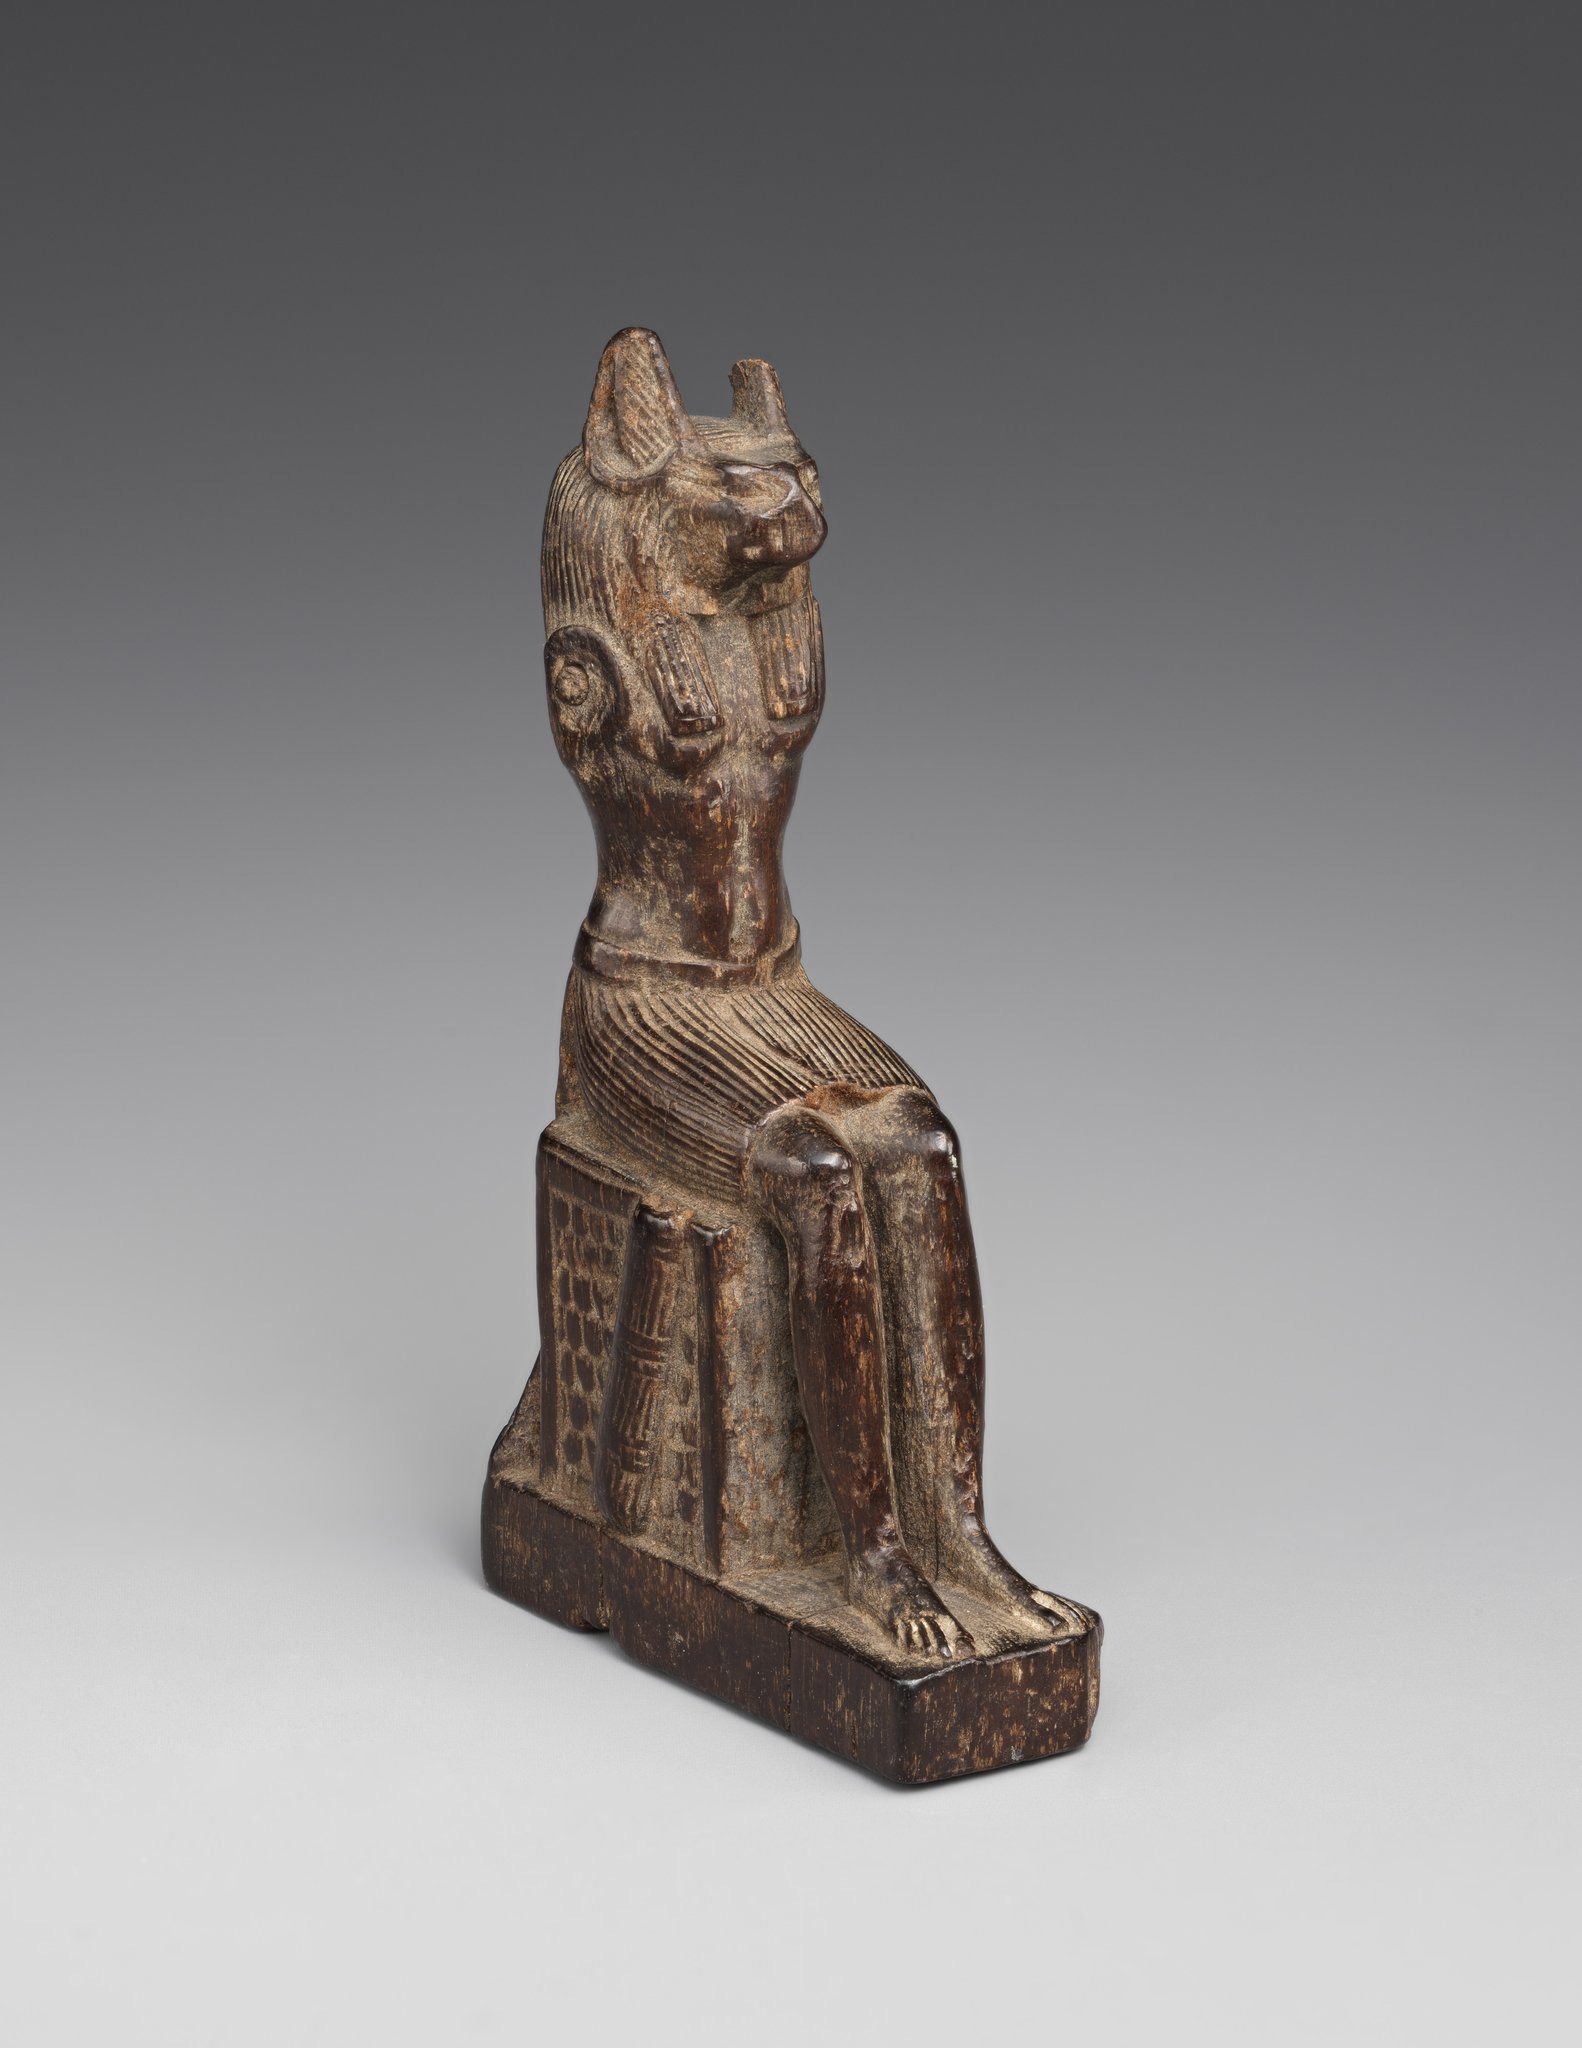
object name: canid, jackal, wepwawet, anugis, seated, tail, quiver, bow, feathered throne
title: A Polymorphic Deity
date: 390-330 BCE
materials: wood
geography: egypt